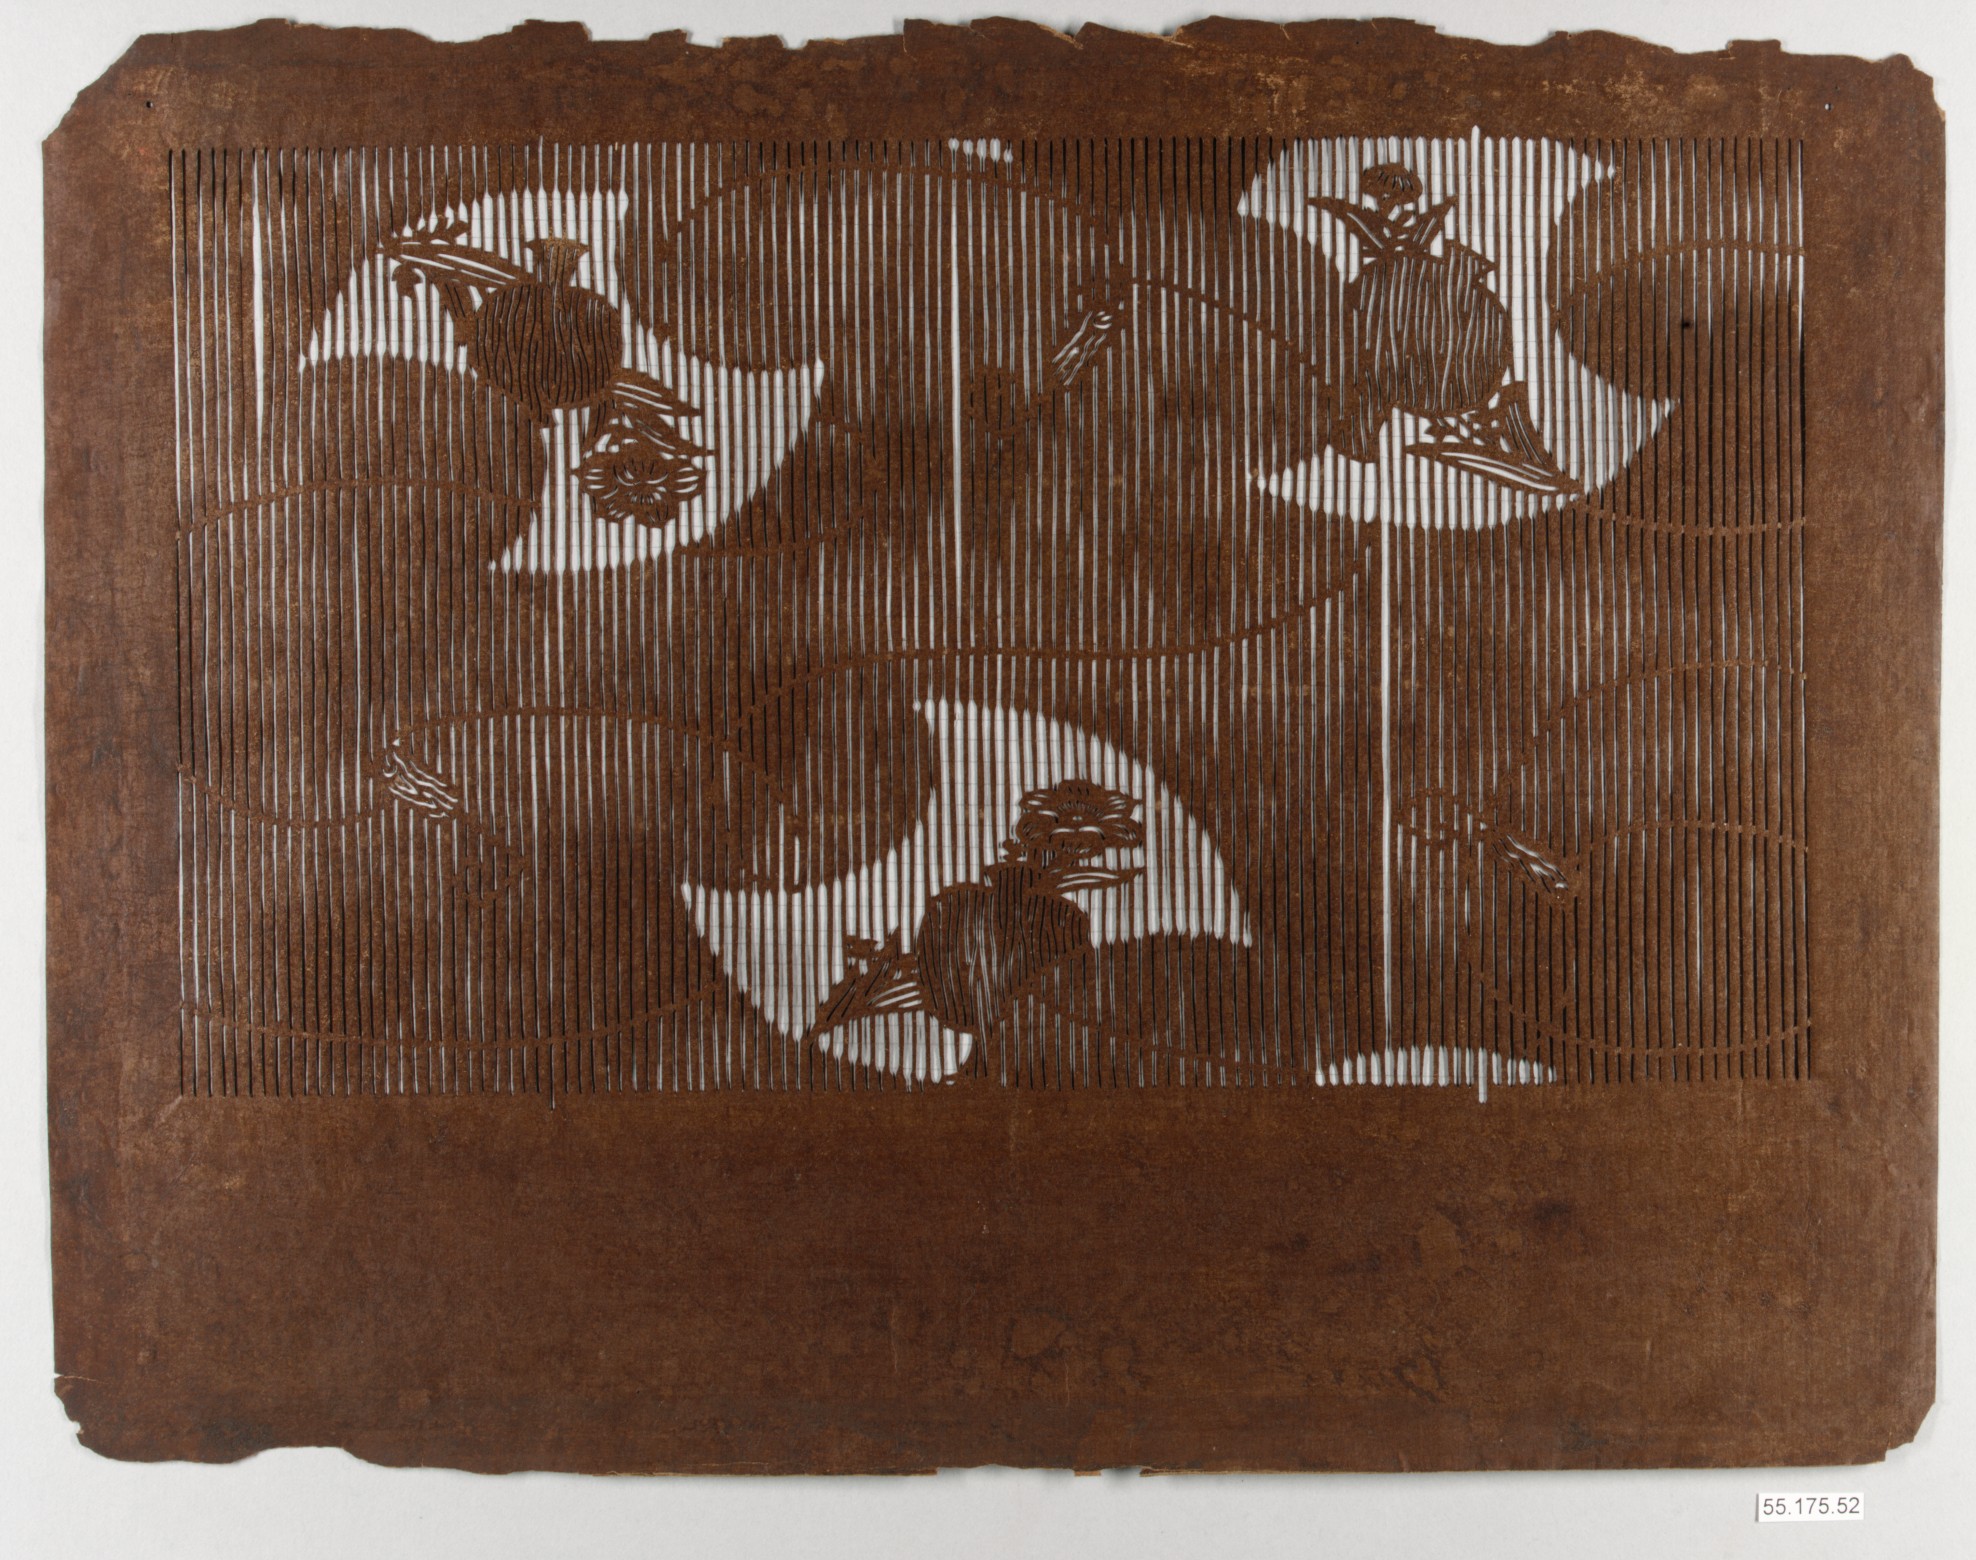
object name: stencil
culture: japanese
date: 1801-1900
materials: paper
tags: flowers